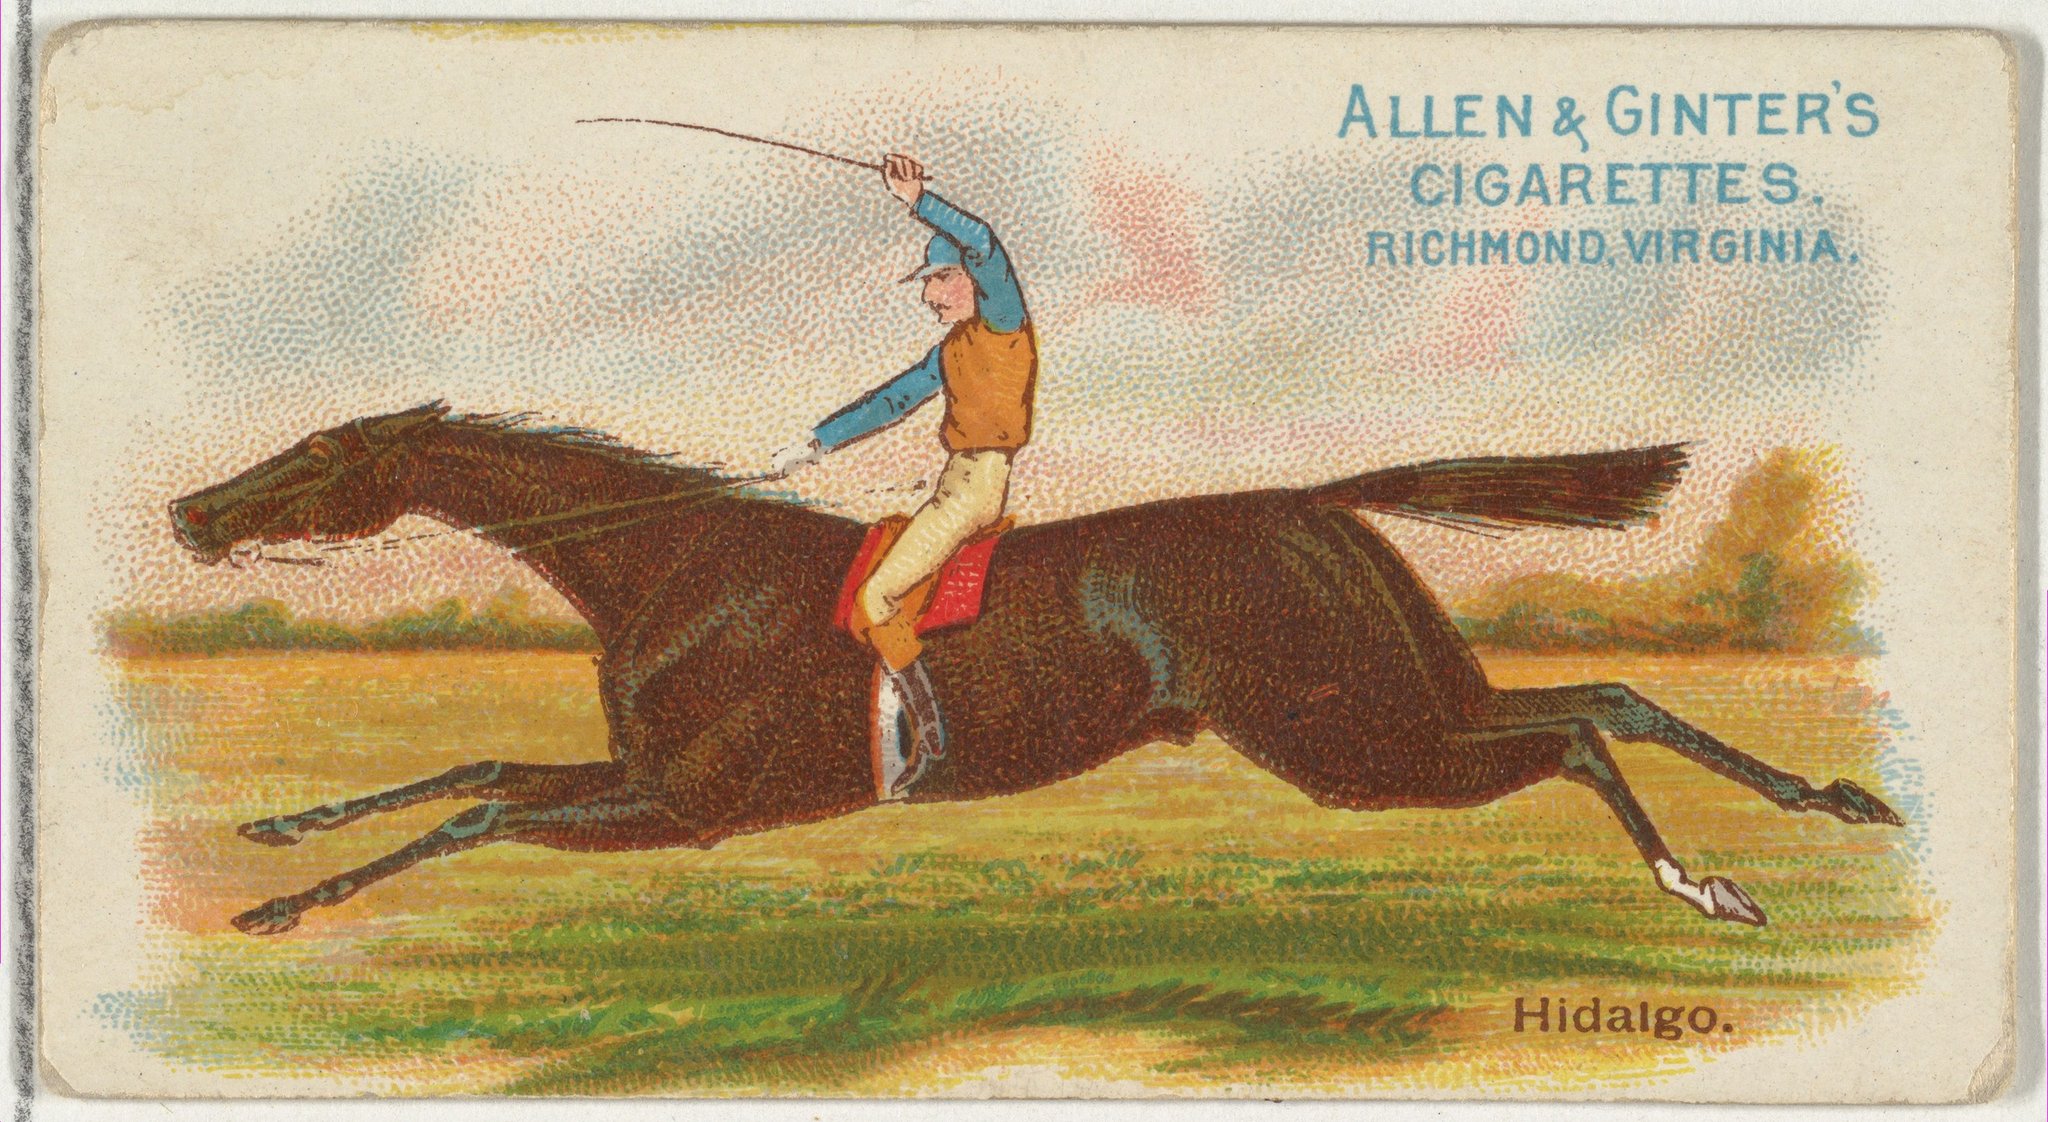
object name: print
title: Hidalgo, from The World's Racers series (N32) for Allen & Ginter Cigarettes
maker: allen & ginter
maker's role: publisher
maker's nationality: american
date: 1888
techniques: color lithograph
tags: men,horses,jockeys